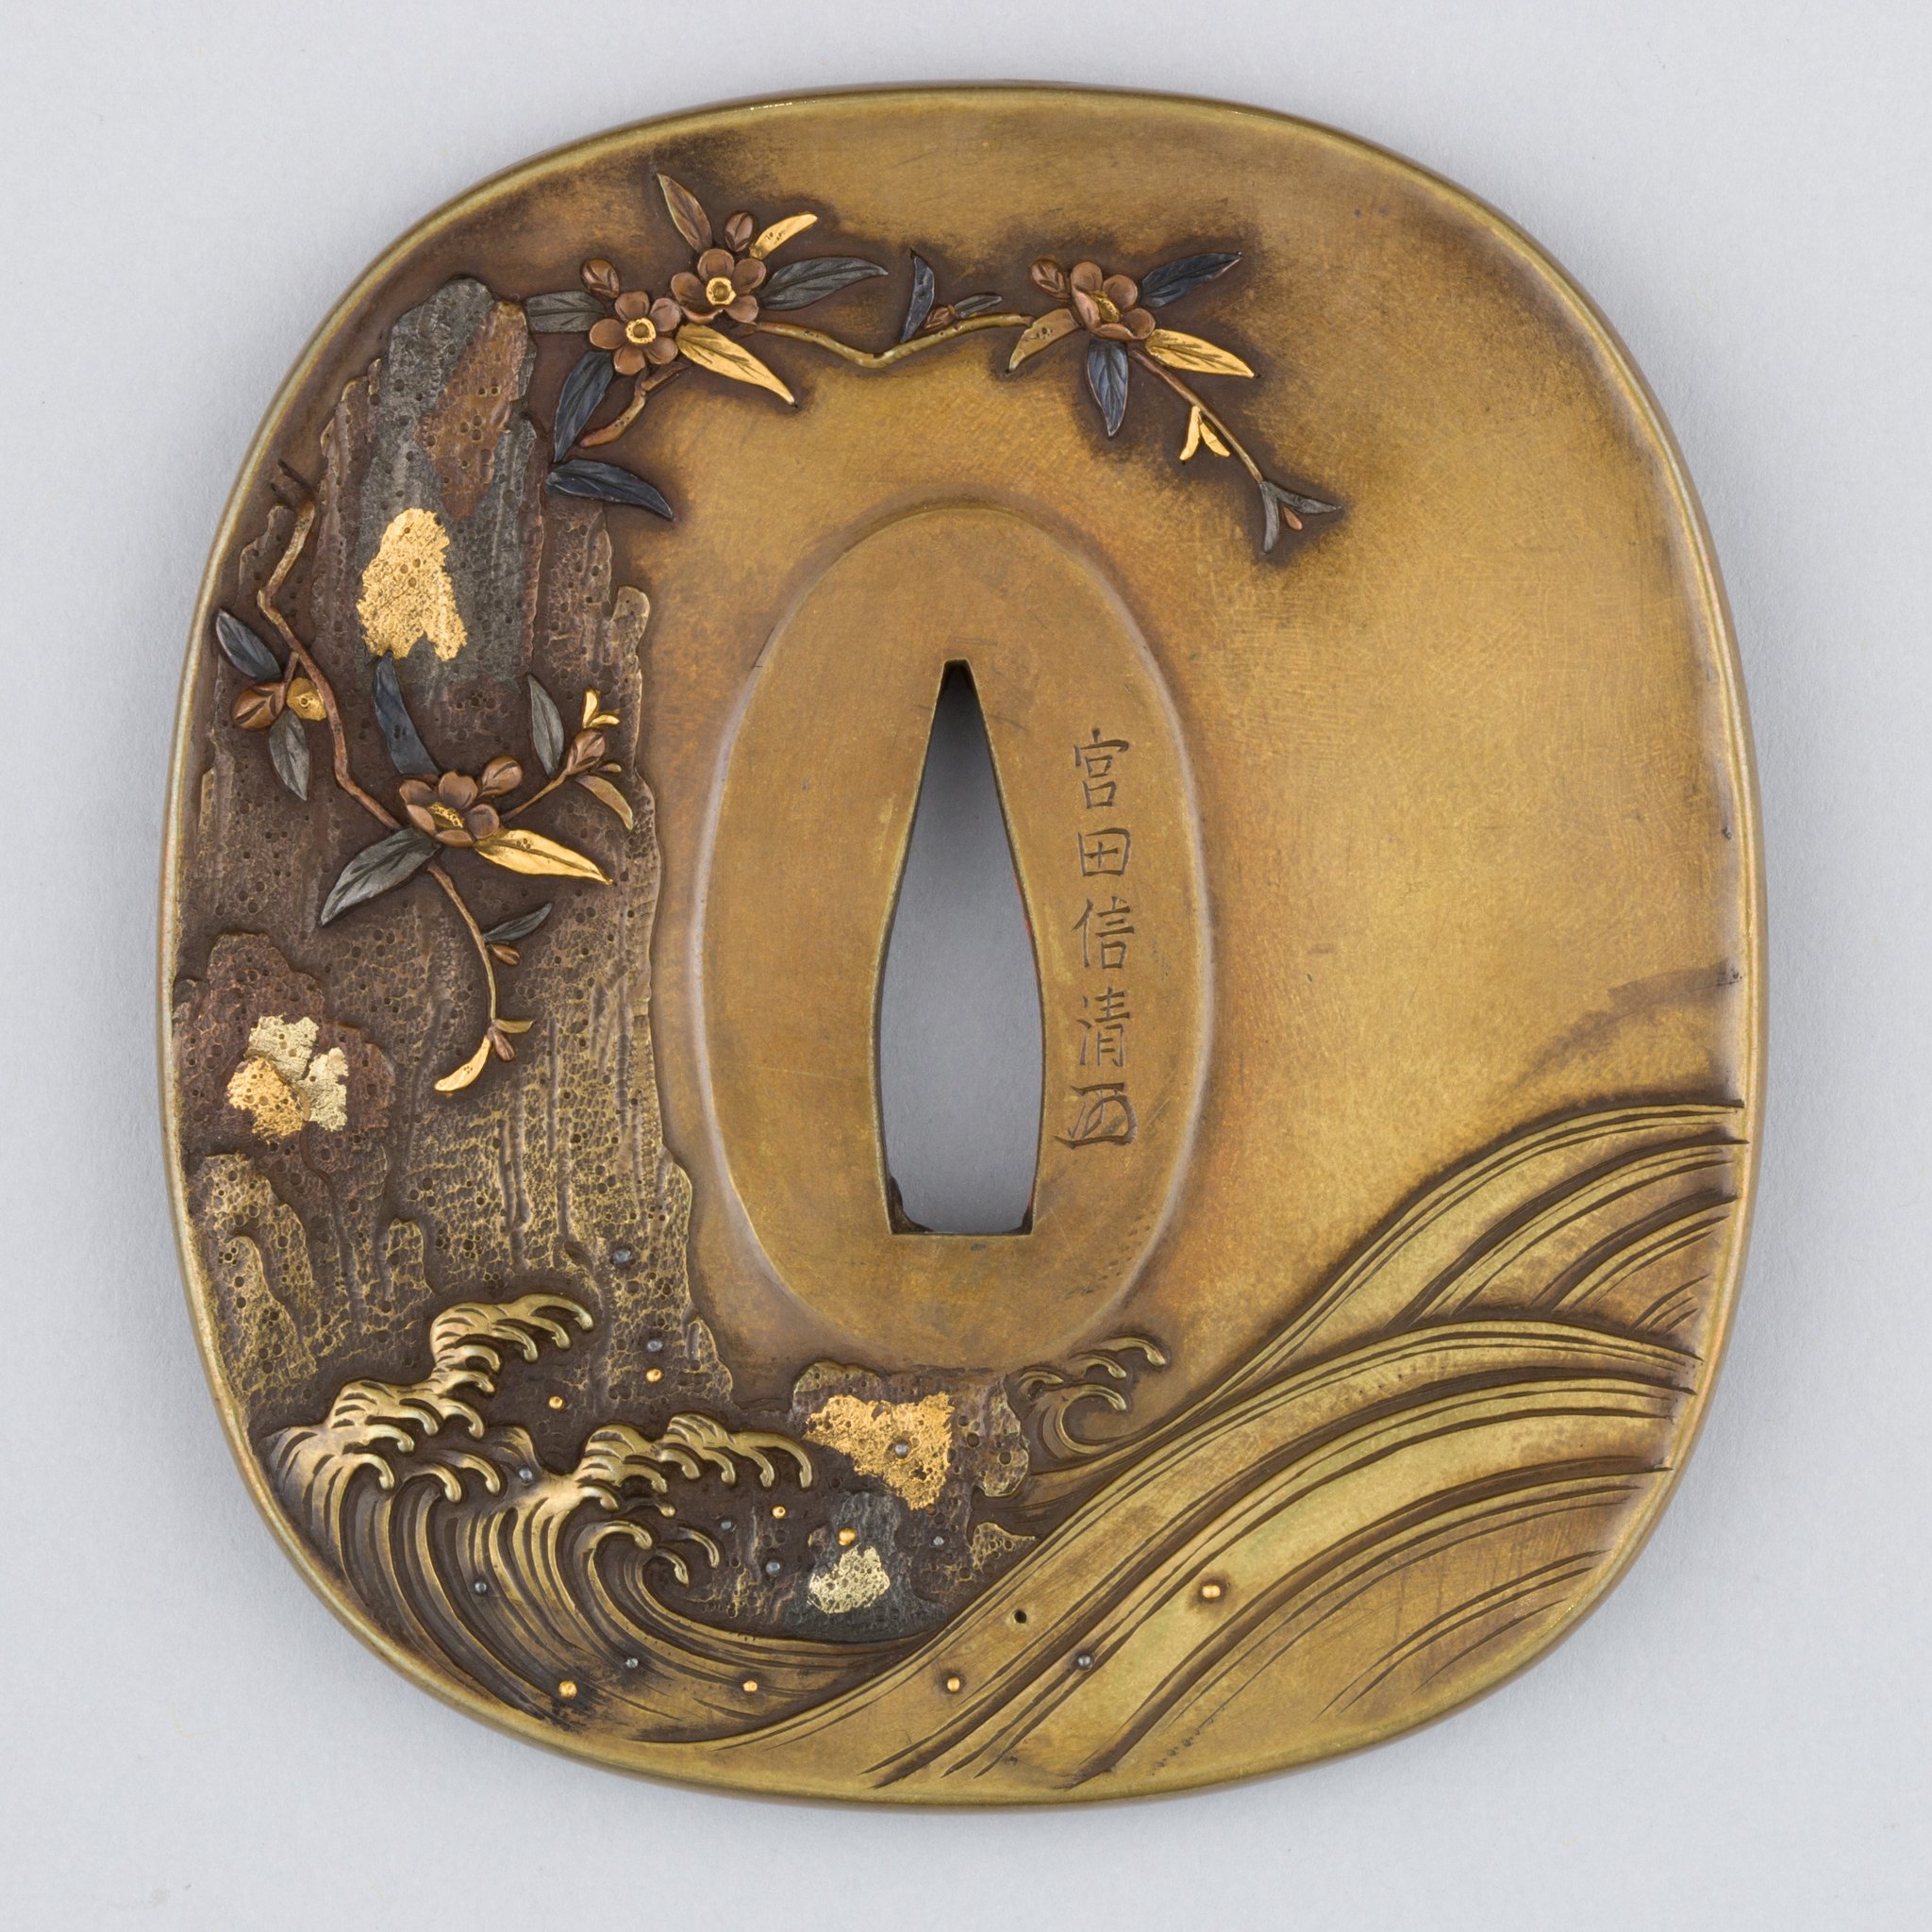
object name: sword guard tsuba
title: Sword Guard (Tsuba)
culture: japanese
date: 1615-1868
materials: copper, copper alloy, gold alloy, silver alloy, gold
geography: japan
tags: flowers,waves